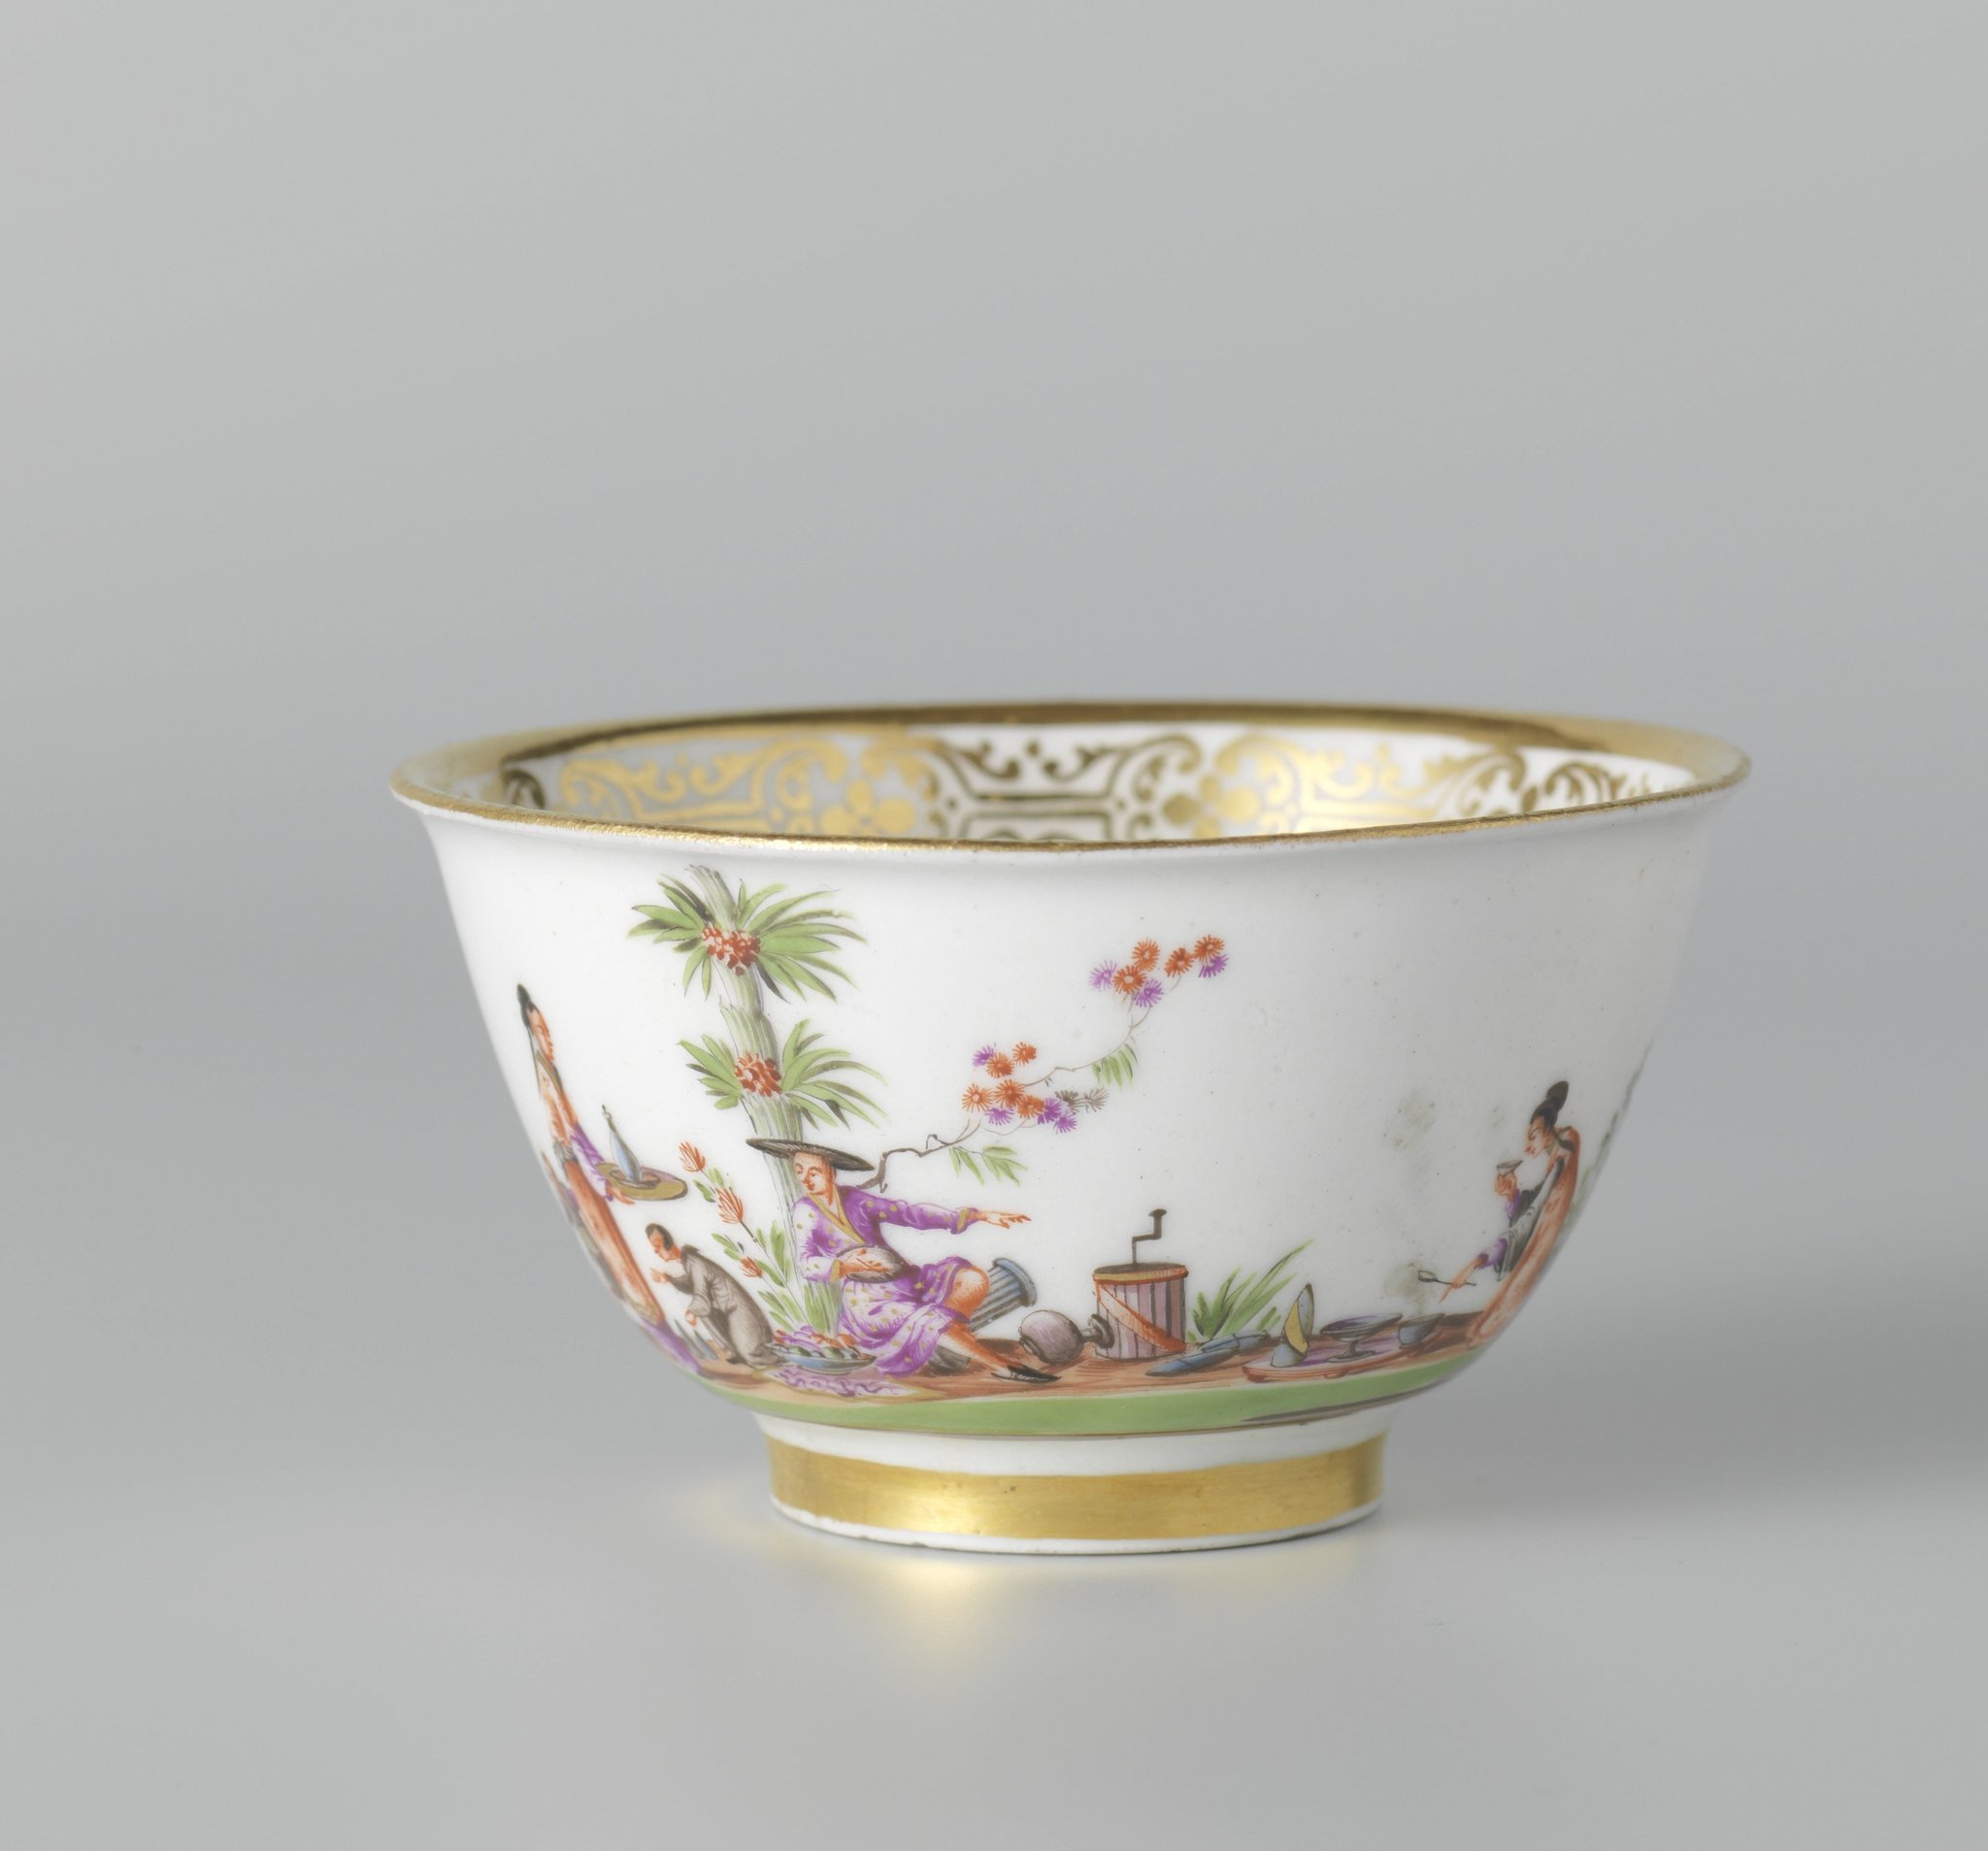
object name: cup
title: Kop, veelkleurig beschilderd met chinoiserieën en het wapen van de Venetiaanse familie Morosini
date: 1731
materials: porcelain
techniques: painted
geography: meissen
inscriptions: factory mark, mark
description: Tea and coffee service with the arms of the Venetian ducal family Morosini. Porcelain in leather travelling case. Meissen, 1731, decorated in the style of Johann Gregorius Höroldt.